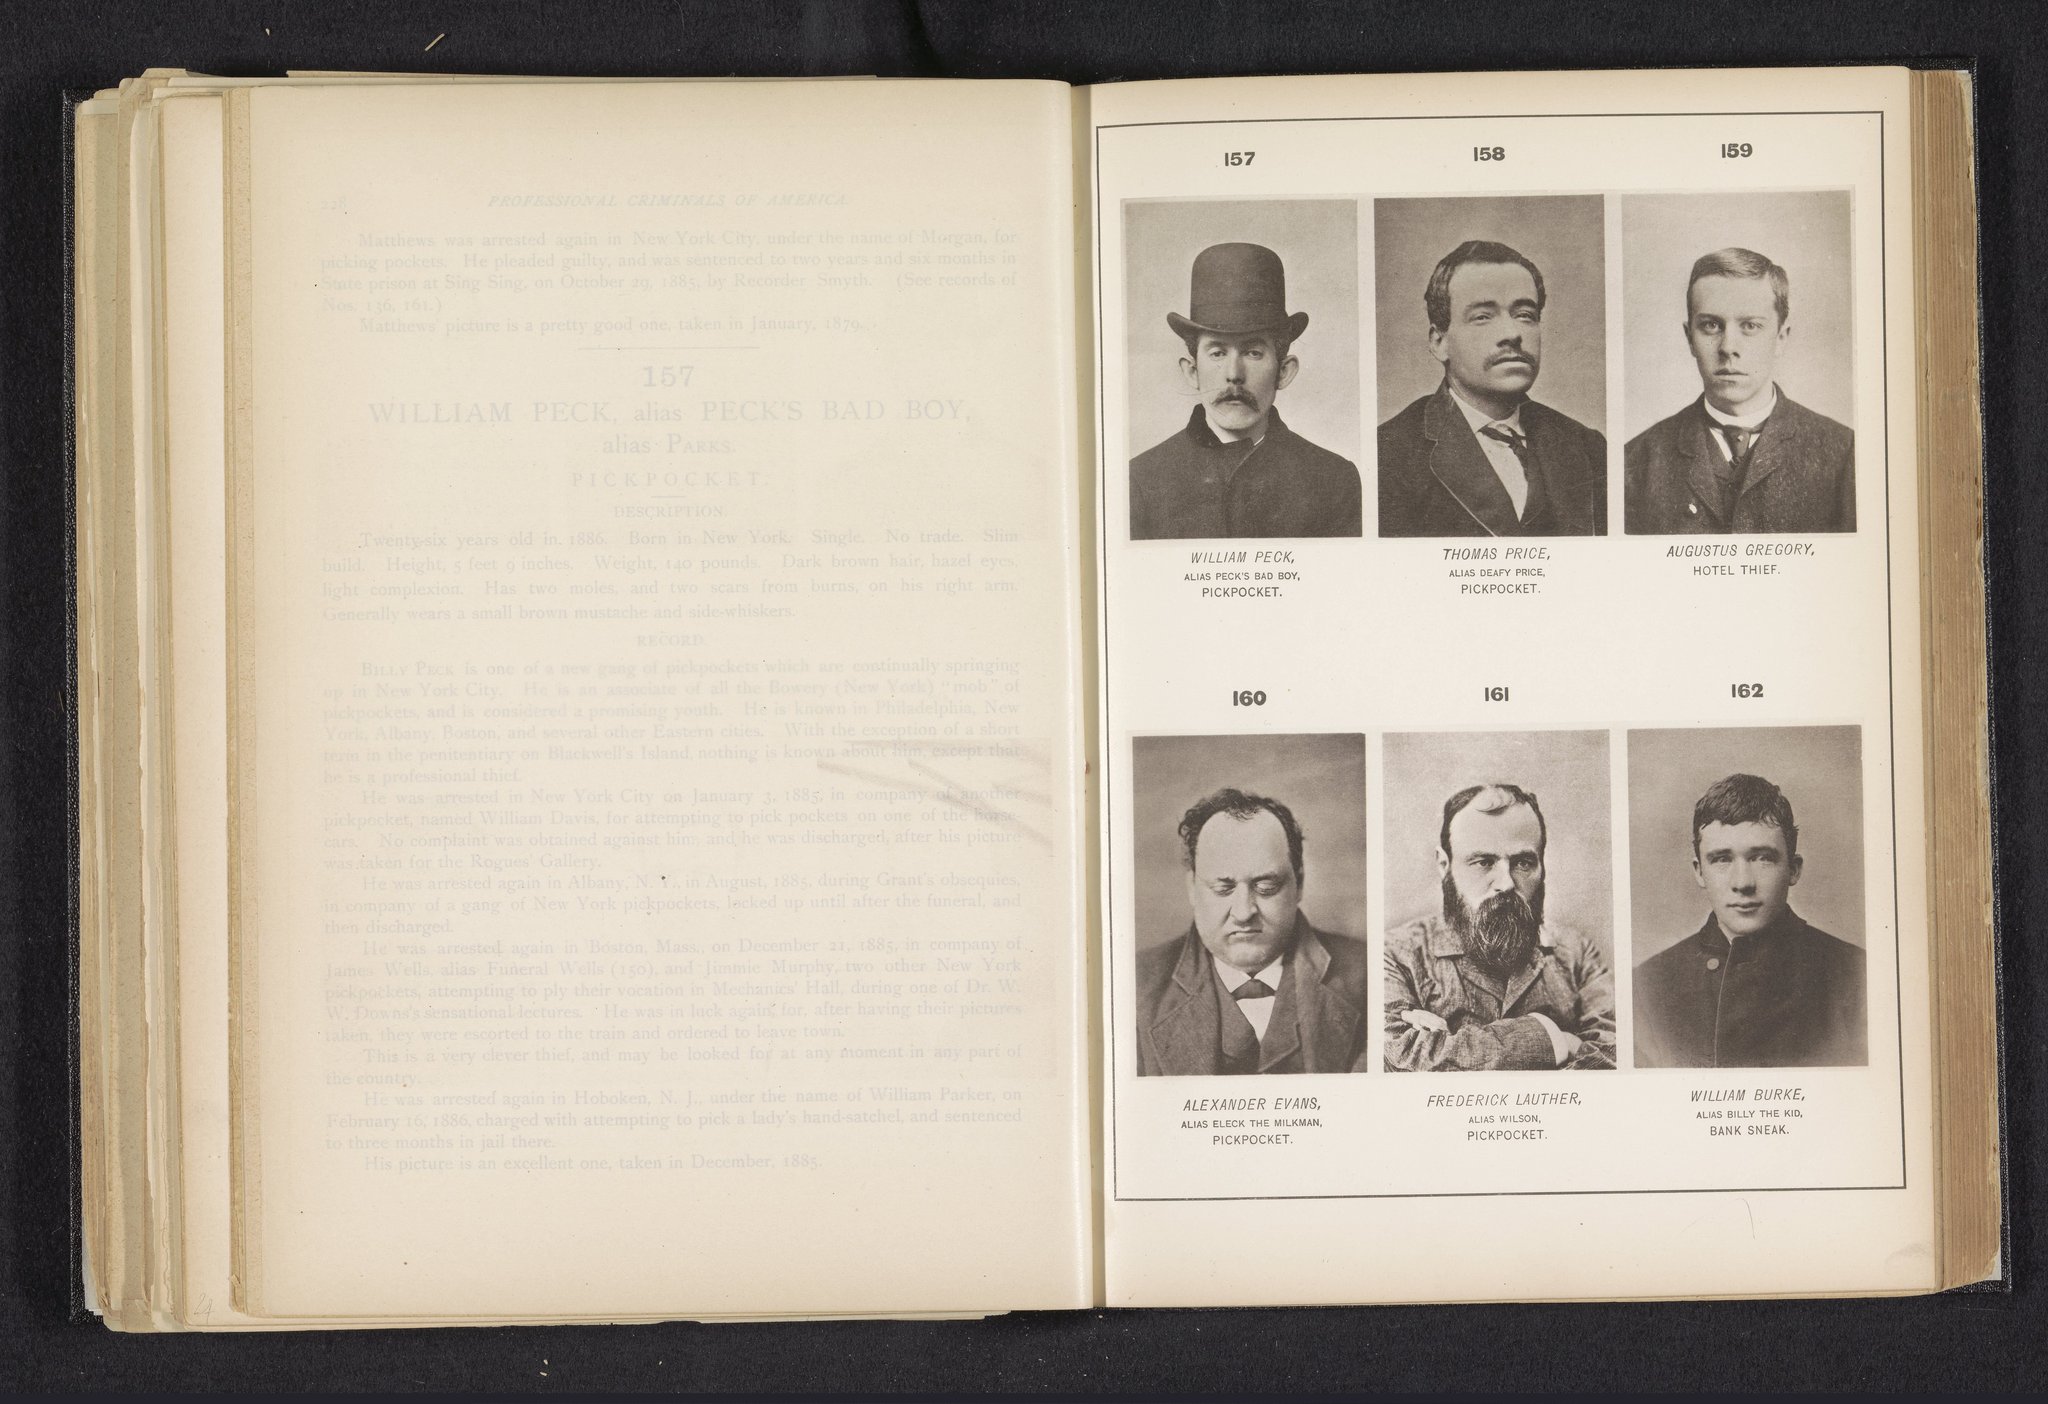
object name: photomechanical print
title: Zes portretten van zakkenrollers en oplichters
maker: Anonymous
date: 1881-1886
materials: paper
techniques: photograph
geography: boston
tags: historical persons not known by name (+ (full) bust portrait), counterfeiter, pickpocket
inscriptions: inscription: ‘William Peck (...) bank sneak.’, number: ‘157 (...) 162’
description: Linksboven William Peck, midden boven Thomas Price, rechtsboven Augustus Gregory, linksonder Alexander Evans, midden onder Frederick Lauther, rechtsonder William Burke.